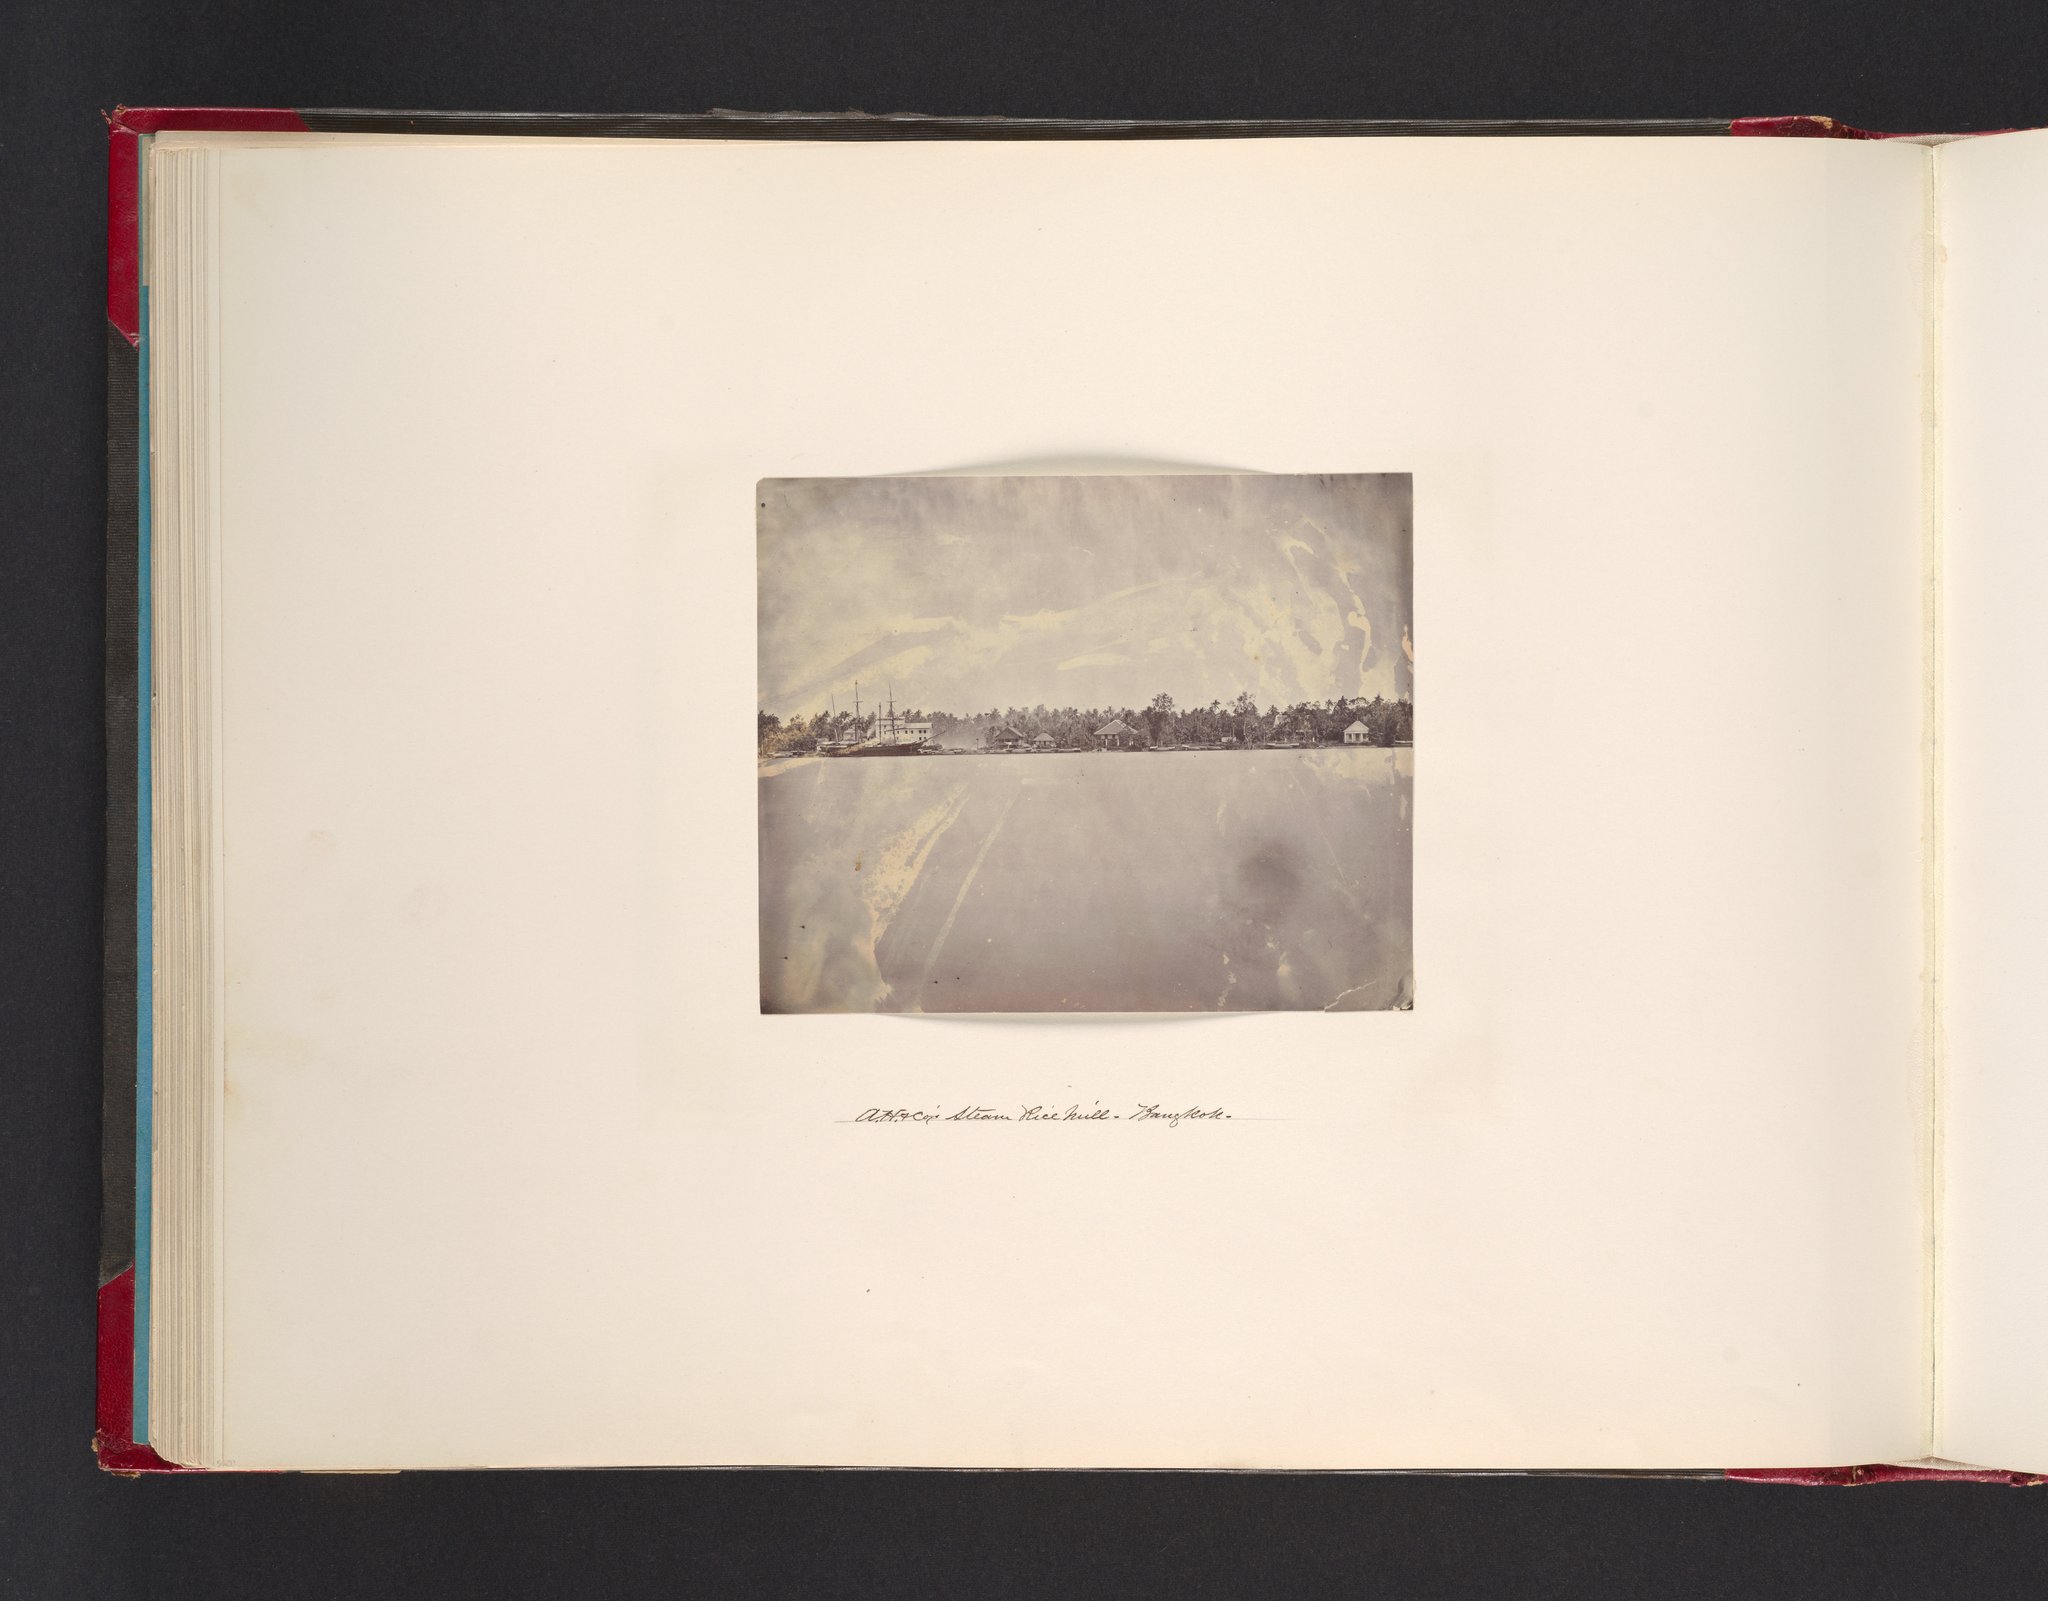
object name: photograph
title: Augustine Heard & Co. Steam Rice Mill, Bangkok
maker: john thomson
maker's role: artist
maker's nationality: british, scottish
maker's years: 1837-1921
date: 1865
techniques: albumen silver print, glass negative